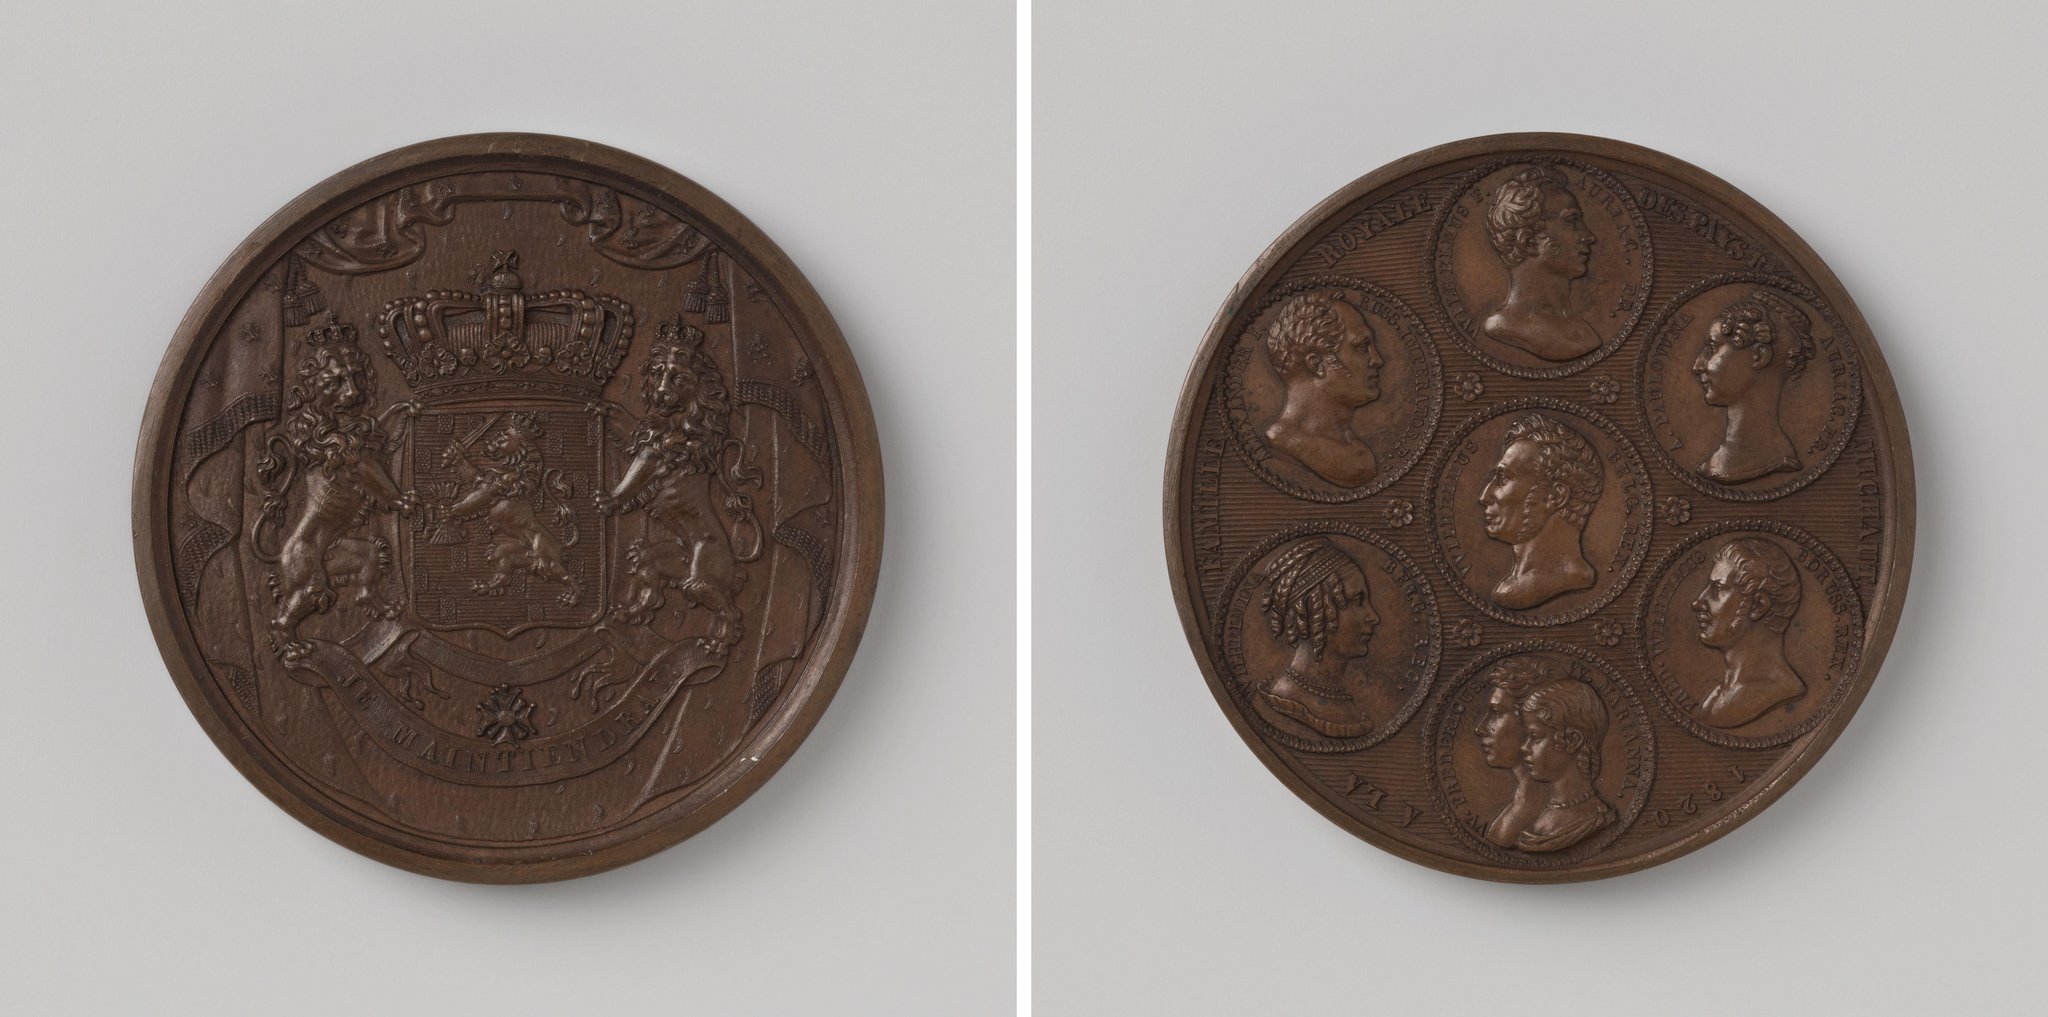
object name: history medal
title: Koninklijke familie, penning aangeboden door Auguste Francois Michaut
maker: auguste francois michaut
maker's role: sculptor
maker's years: 1786-1879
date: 1820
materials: bronze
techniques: striking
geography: netherlands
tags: anna paulowna romanowa, berlin, william i of the netherlands, the hague, william ii of the netherlands, alexander i (tsaar van rusland), paris, sculptor, auguste francois michaut, frederik willem iii koning van pruisen, frederik (prins der nederlanden), voorburg, marianne (prinses der nederlanden)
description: Bronzen penning. Voorzijde: gekroond wapenschild, geflankeerd door twee gekroonde leeuwen boven ridderorde en wimpel met opschrift; achtergrond: hermelijnen mantel. Keerzijde: medaillon met borststuk man binnen omschrift en bloemenkrans, omgeven door zes medaillons met borststukken van drie mannen, twee vrouwen en twee kinderen (gezamelijk in een medaillon), allen binnen omschrift.